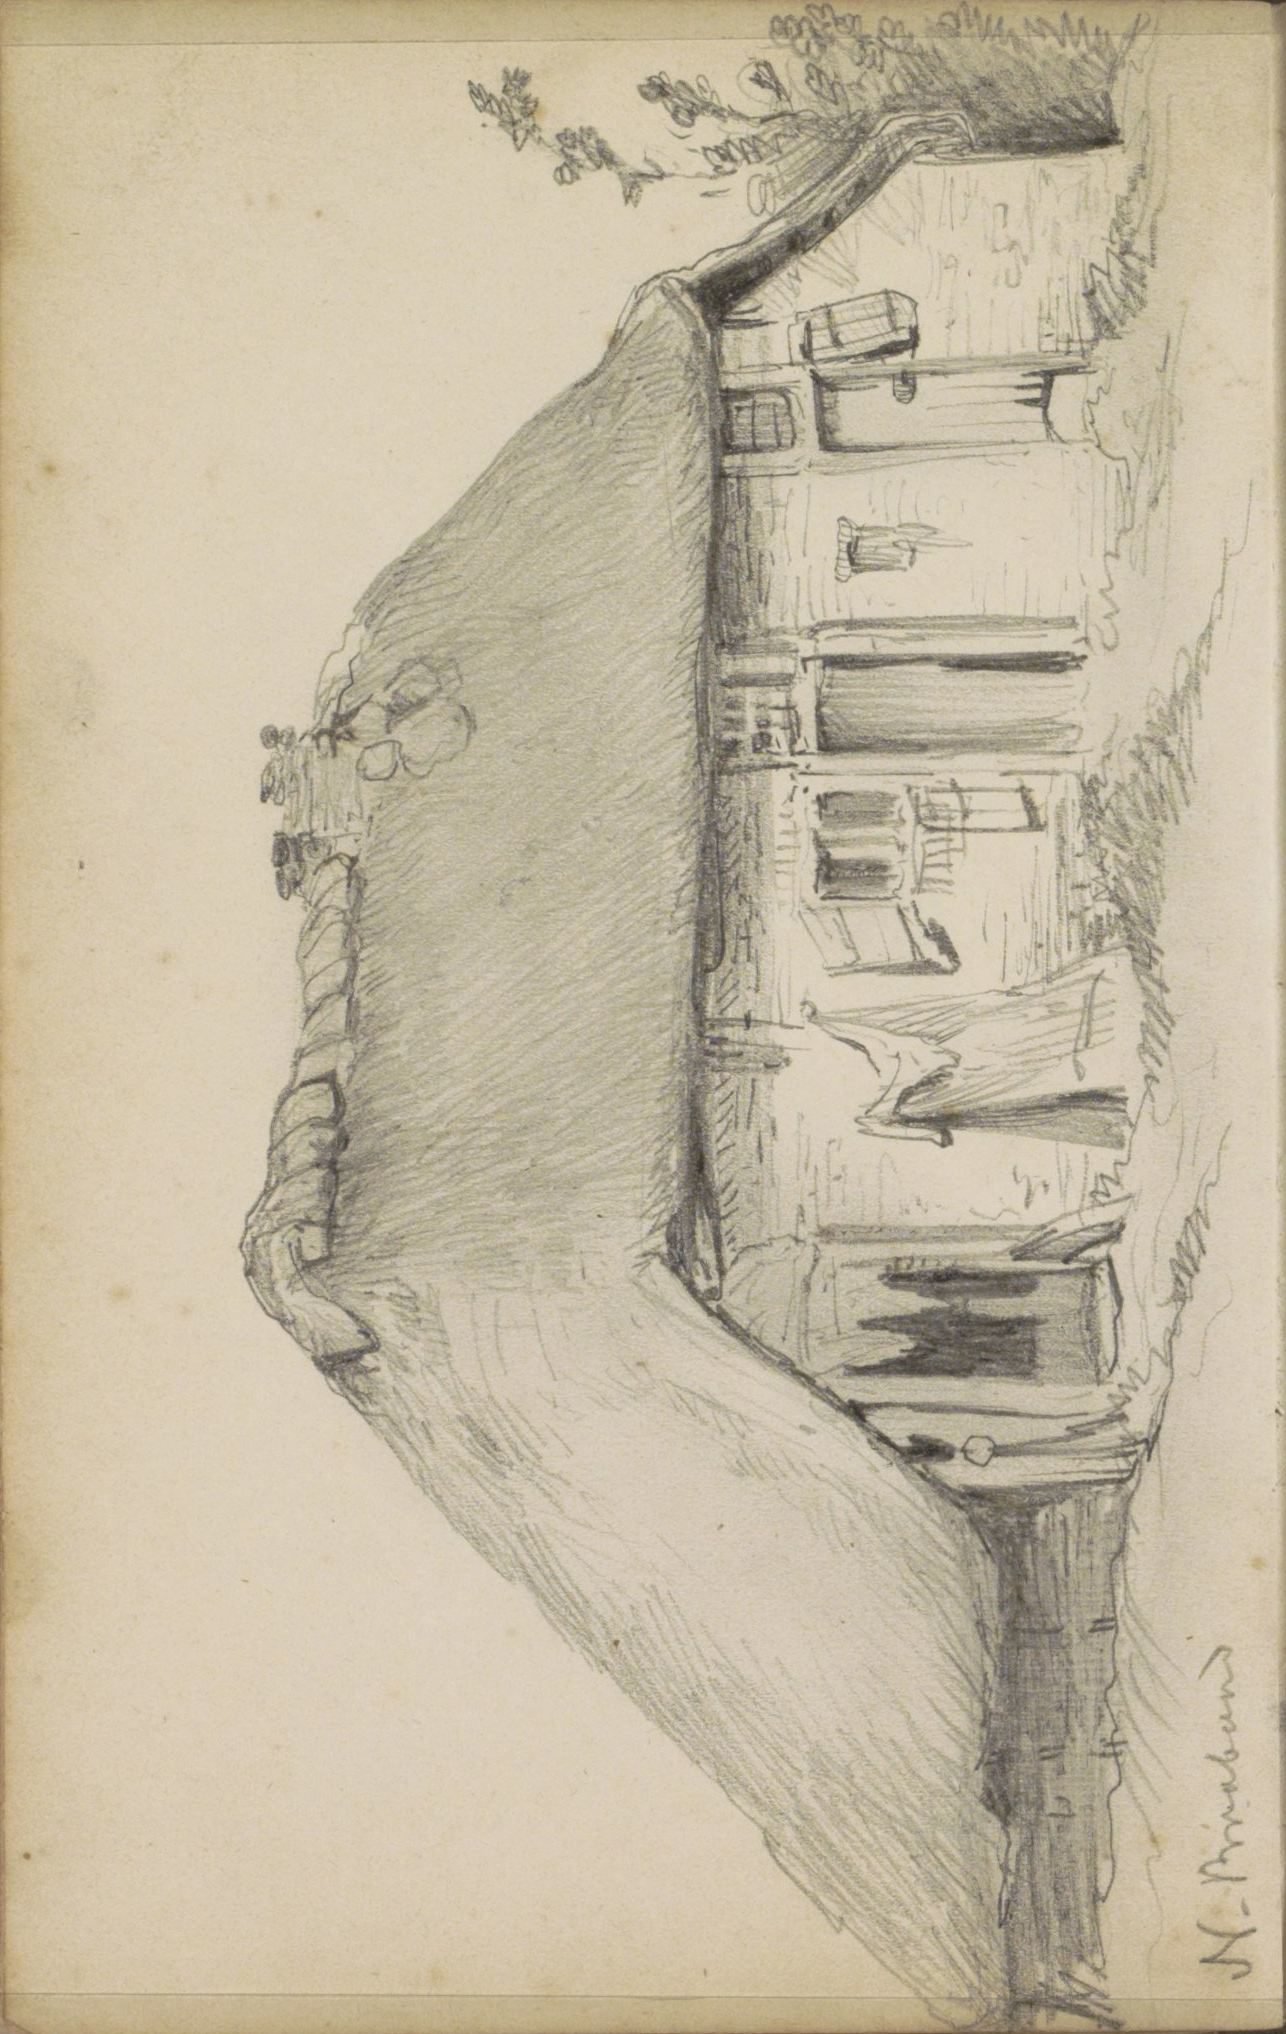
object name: sketchbook leaf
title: Hut met rieten kap in Noord-Brabant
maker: johannes tavenraat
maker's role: draughtsman, painter, print maker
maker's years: 1809-1881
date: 1839-1872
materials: paper, pencil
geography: north brabant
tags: farm (building)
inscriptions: annotation: ‘N.Braband’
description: Blad 28 verso uit een schetsboek met 73 bladen.